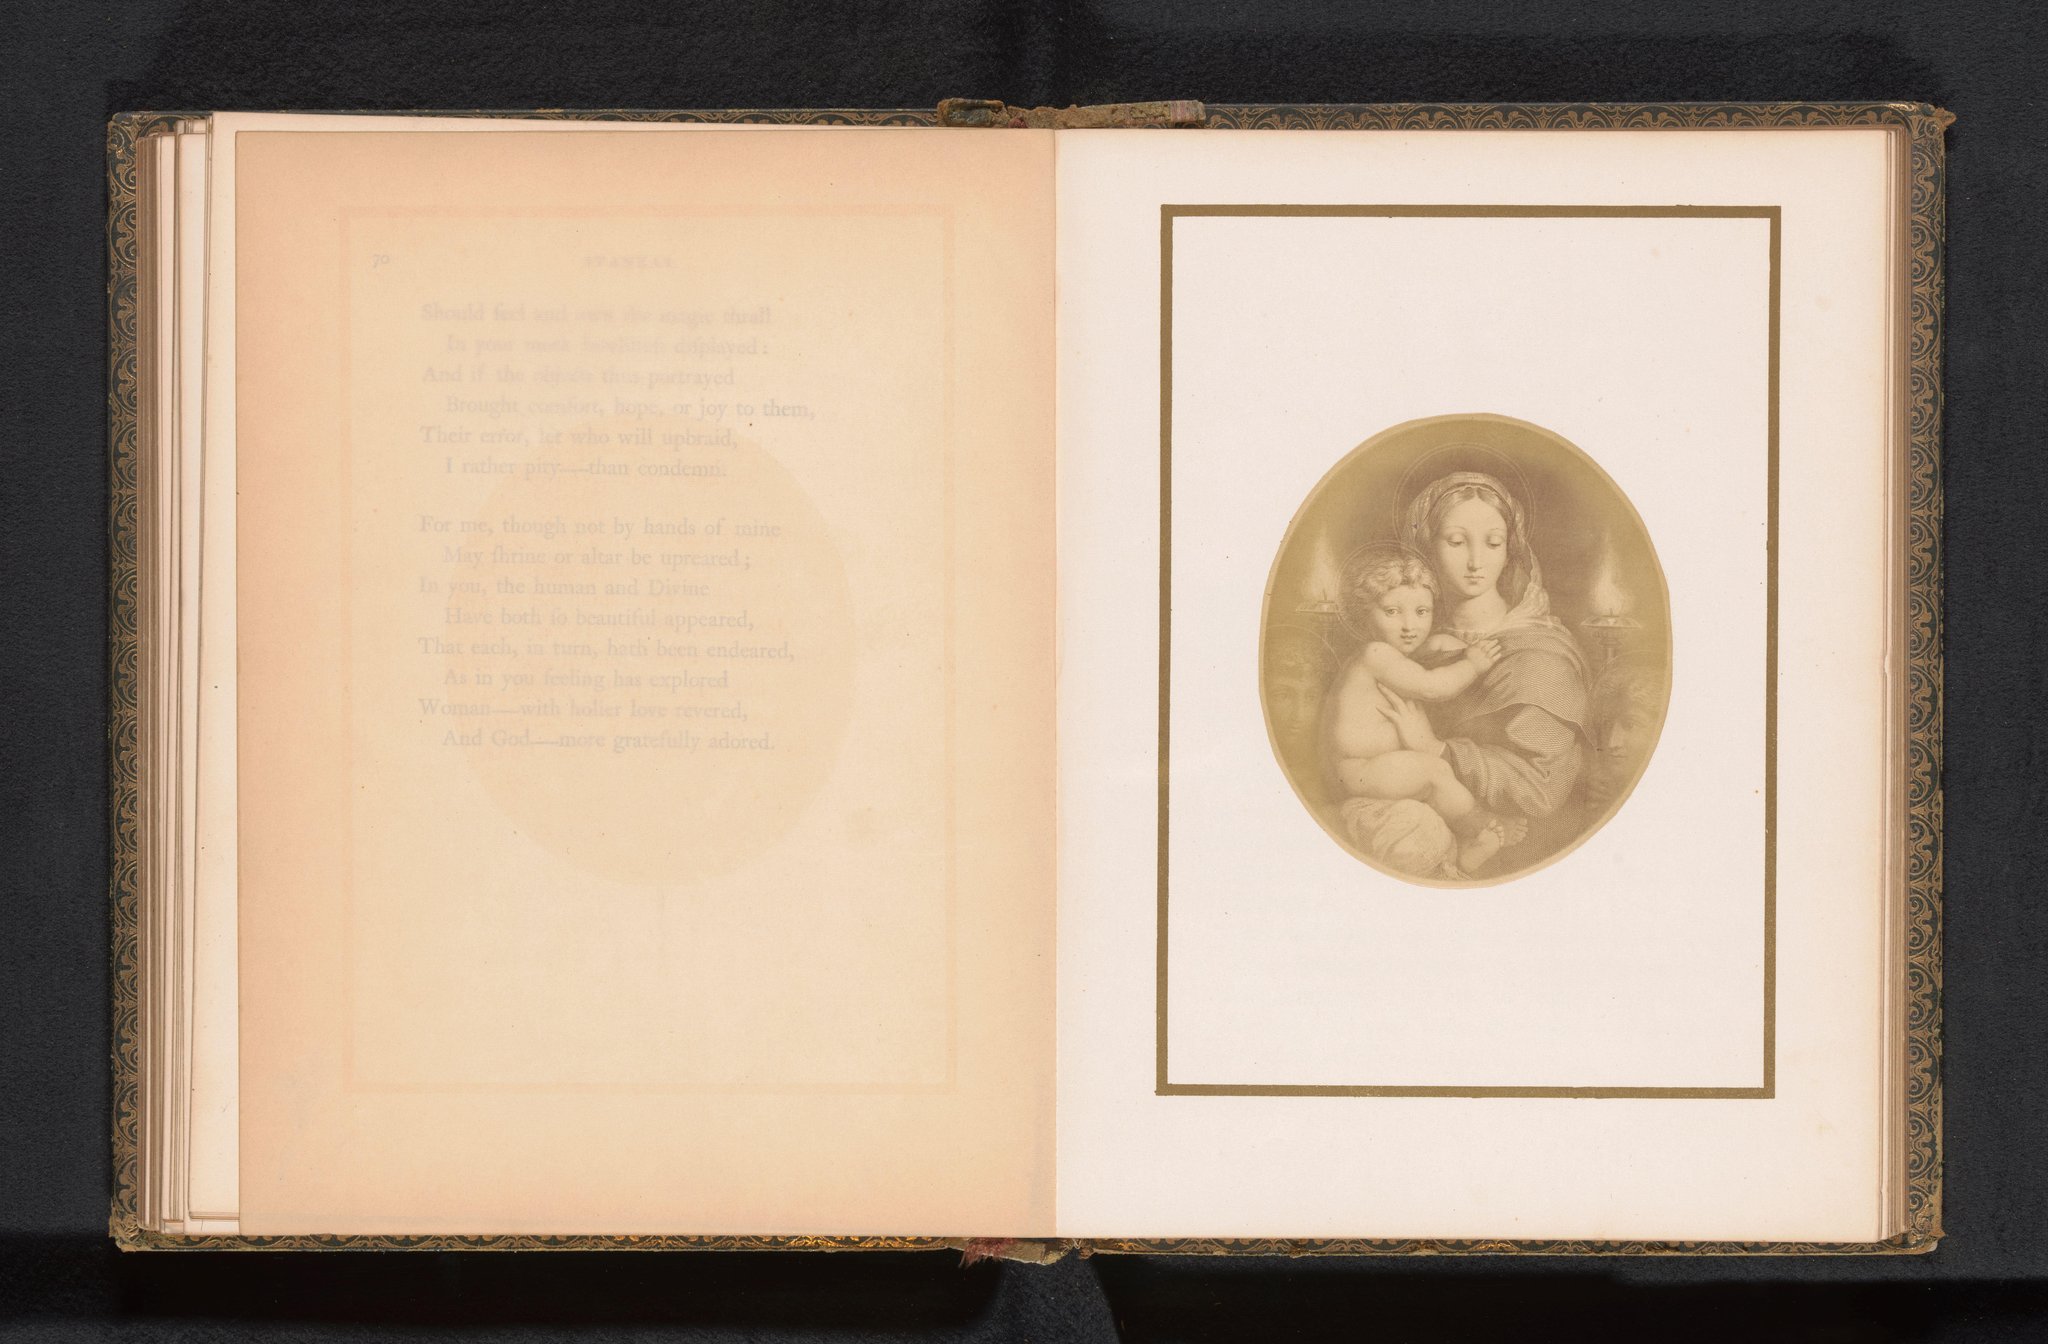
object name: photograph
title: Fotoreproductie van een prent naar een schilderij, voorstellende Maria met Kind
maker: e. hufnagel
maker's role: fotograaf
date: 1855-1860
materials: photographic support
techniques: albumen print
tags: the virgin mary